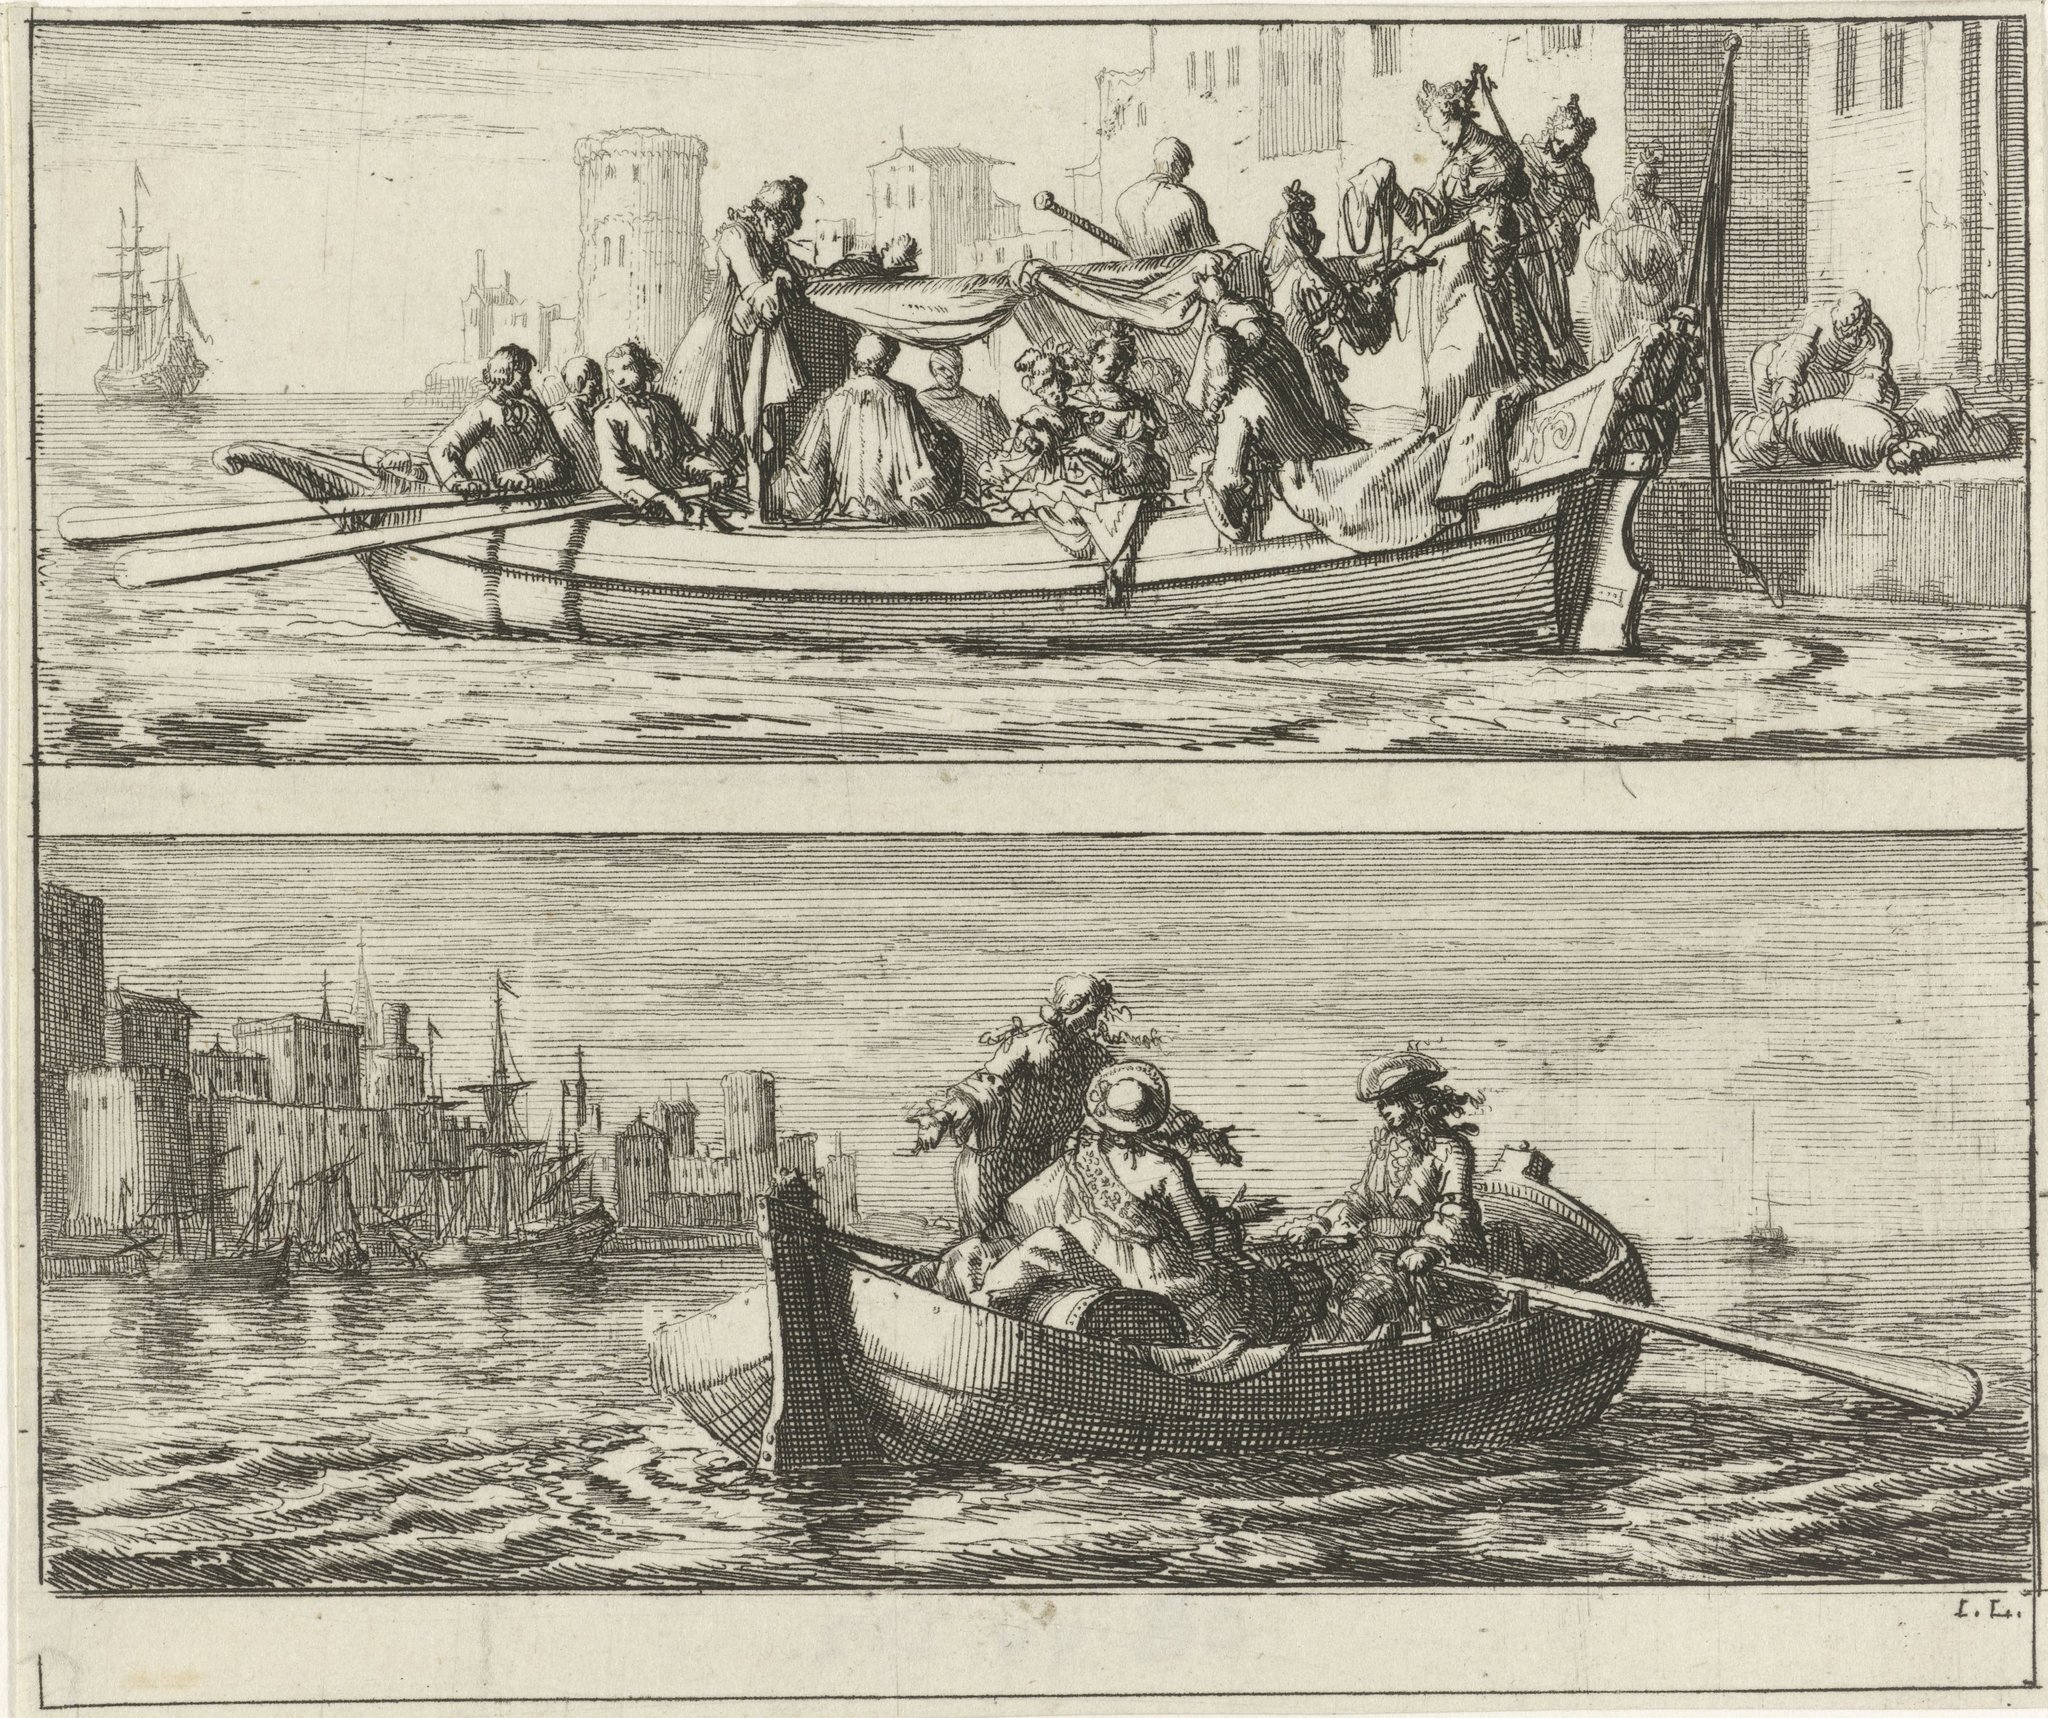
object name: print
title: Vlucht van de koning en koningin naar Frankrijk, 1688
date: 1689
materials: paper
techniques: etching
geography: amsterdam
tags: jacobus ii (koning van engeland en schotland), flight of ruler from adversary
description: Proefdruk van illustratie uit: Pers, Dirck Pietersz. Romeynschen adelaer, waer in de loffelĳcke en lasterlĳcke daden der Romeynsche koningen, en keyseren, verhandelt werden, 3 delen. Utrecht: Jurriaen van Poolsum, 1689, fol. 800. Deze prent is ook genummerd FMH 2696 als illustratie voor: Lambert van den Bosch, Het leven en bedryf van Willem de Darde, Jan Claesz ten Hoorn, Amsterdam 1694, 4 delen.